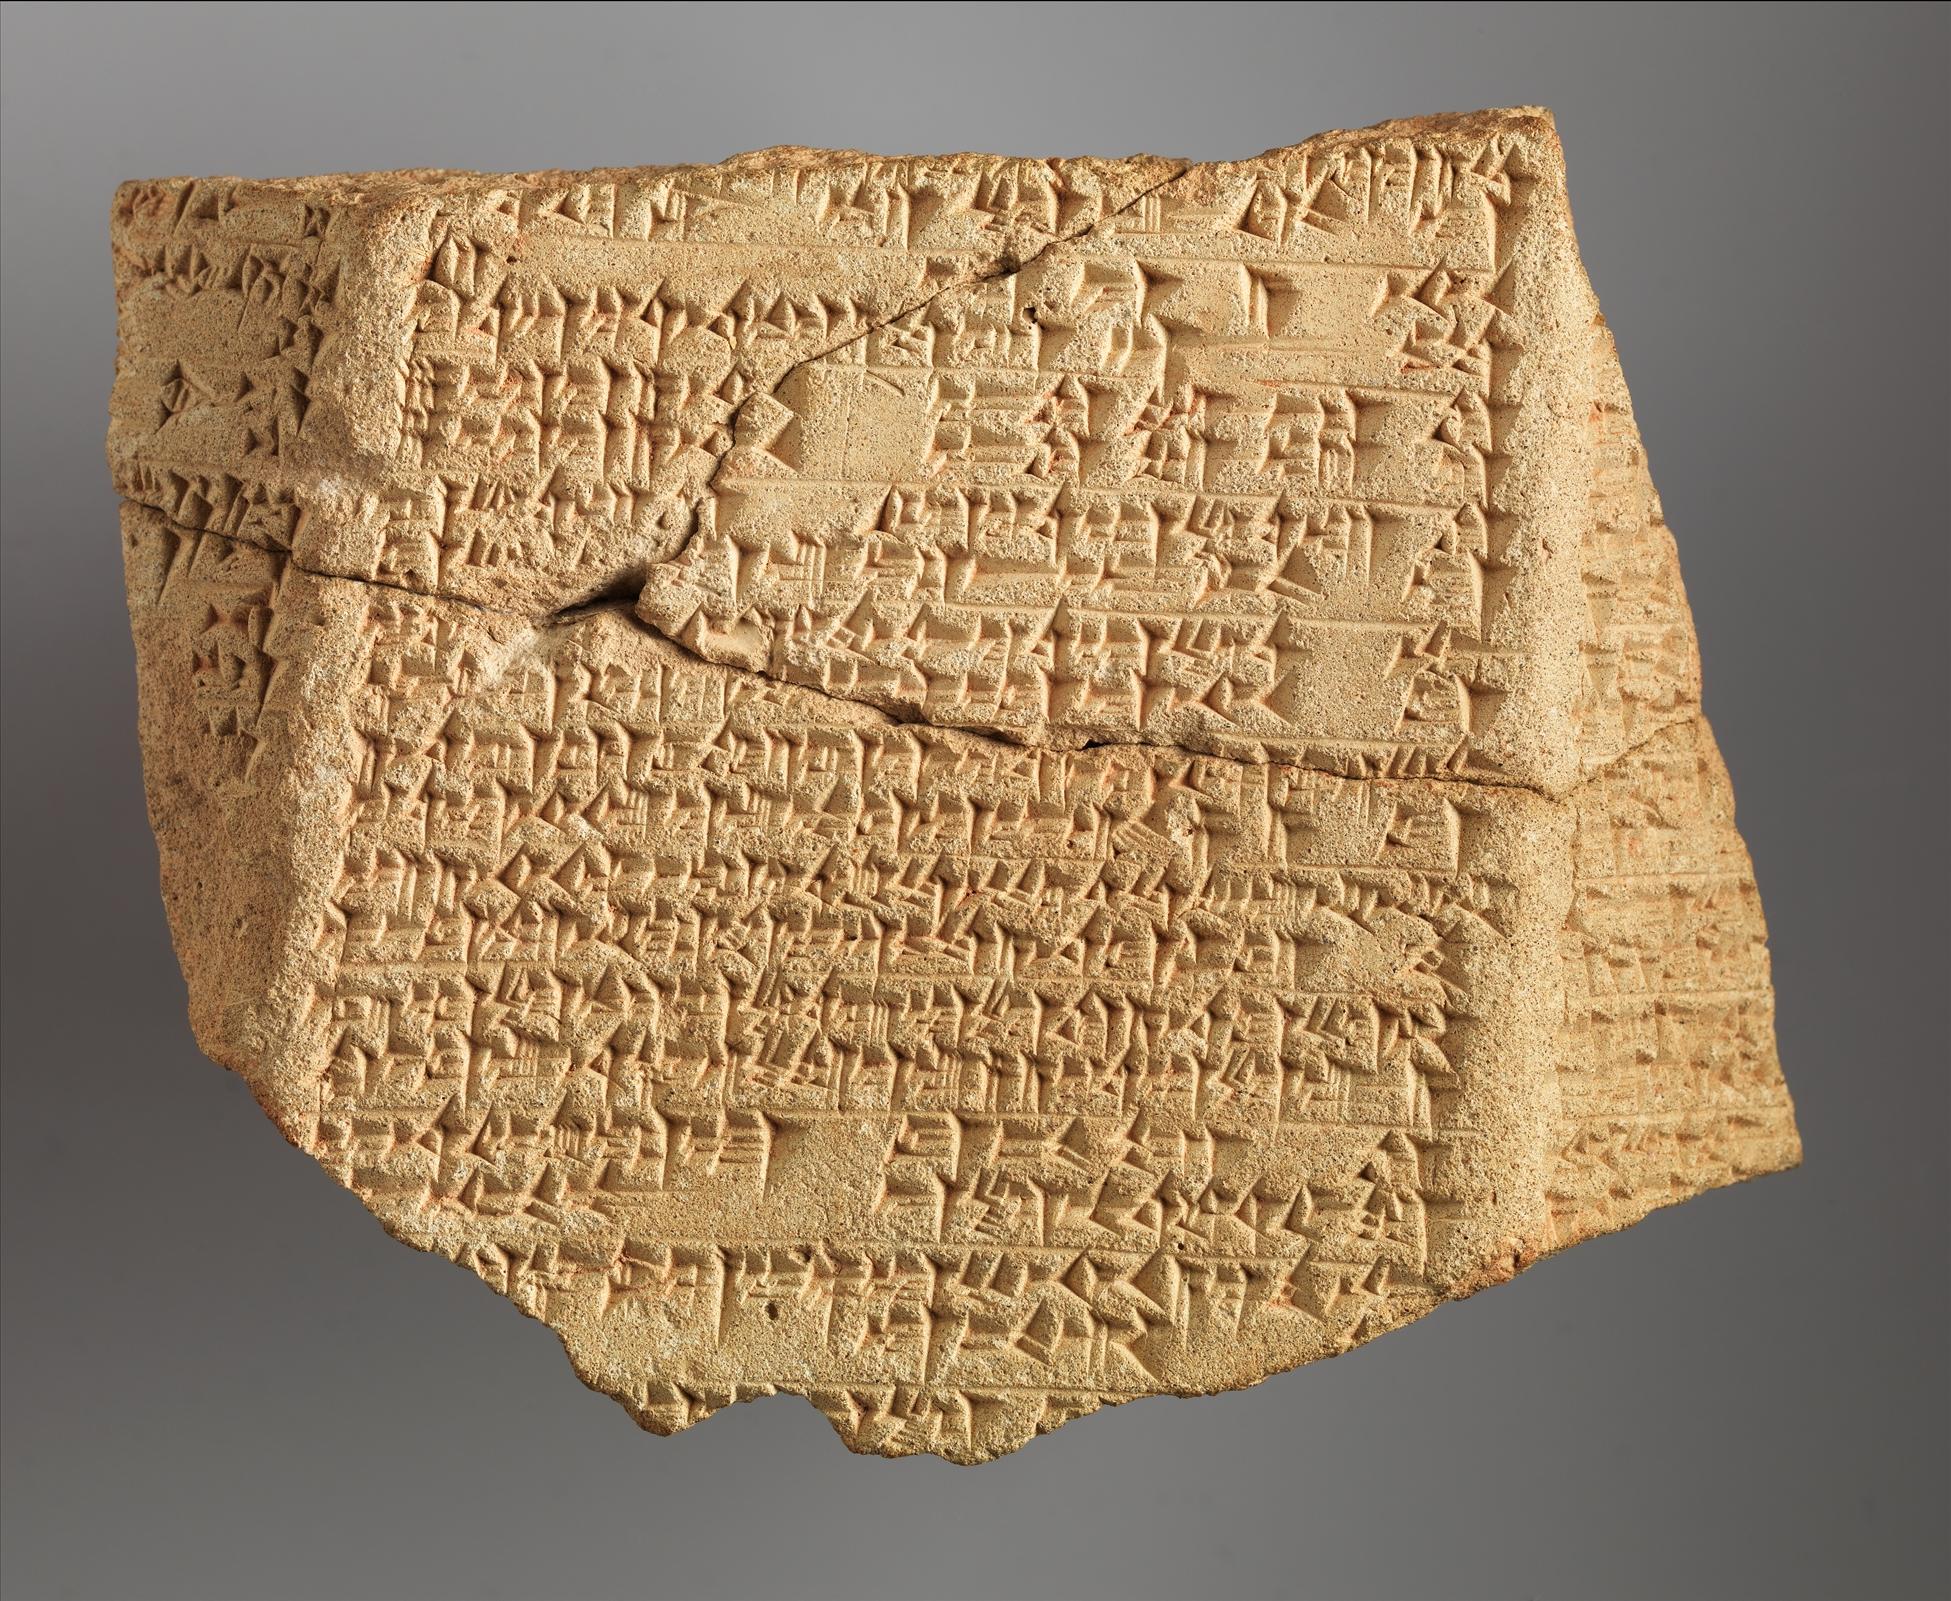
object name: kudurru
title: Fragment of inscribed prism (kudurru)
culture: babylonian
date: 700-501 BCE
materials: clay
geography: mesopotamia